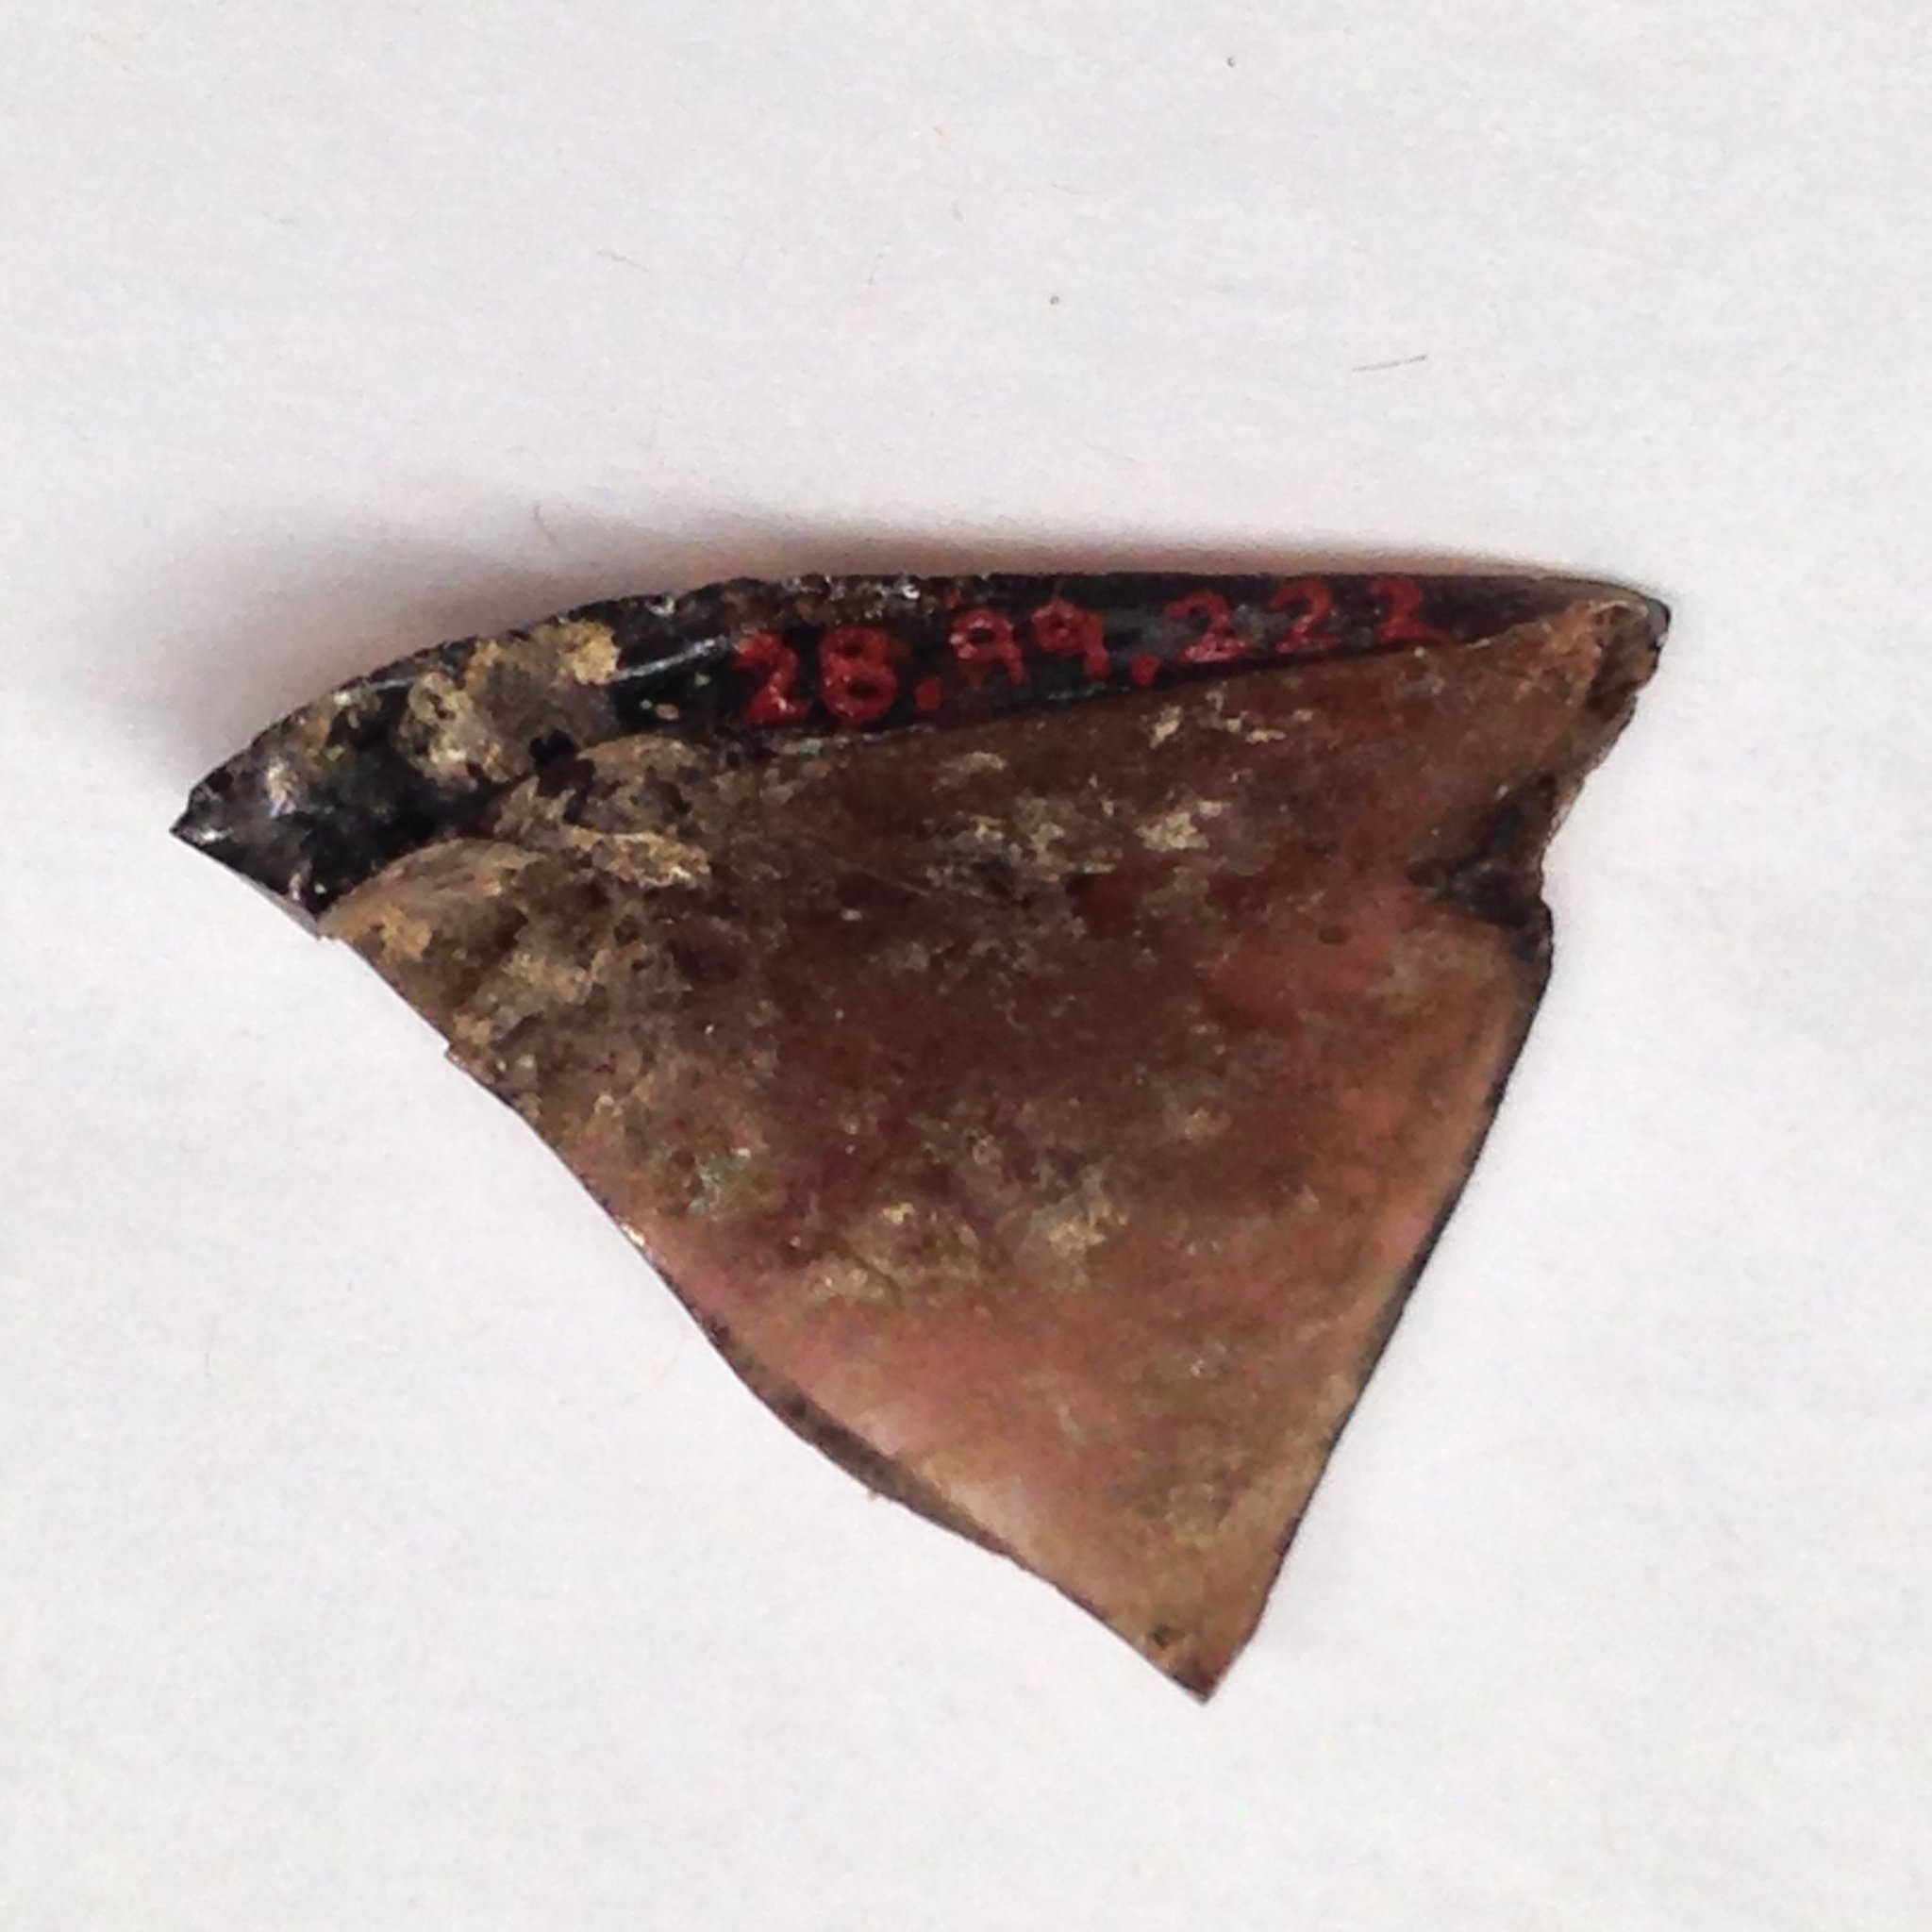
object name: fragment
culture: european or middle eastern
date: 1150-1250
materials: ceramic, glass